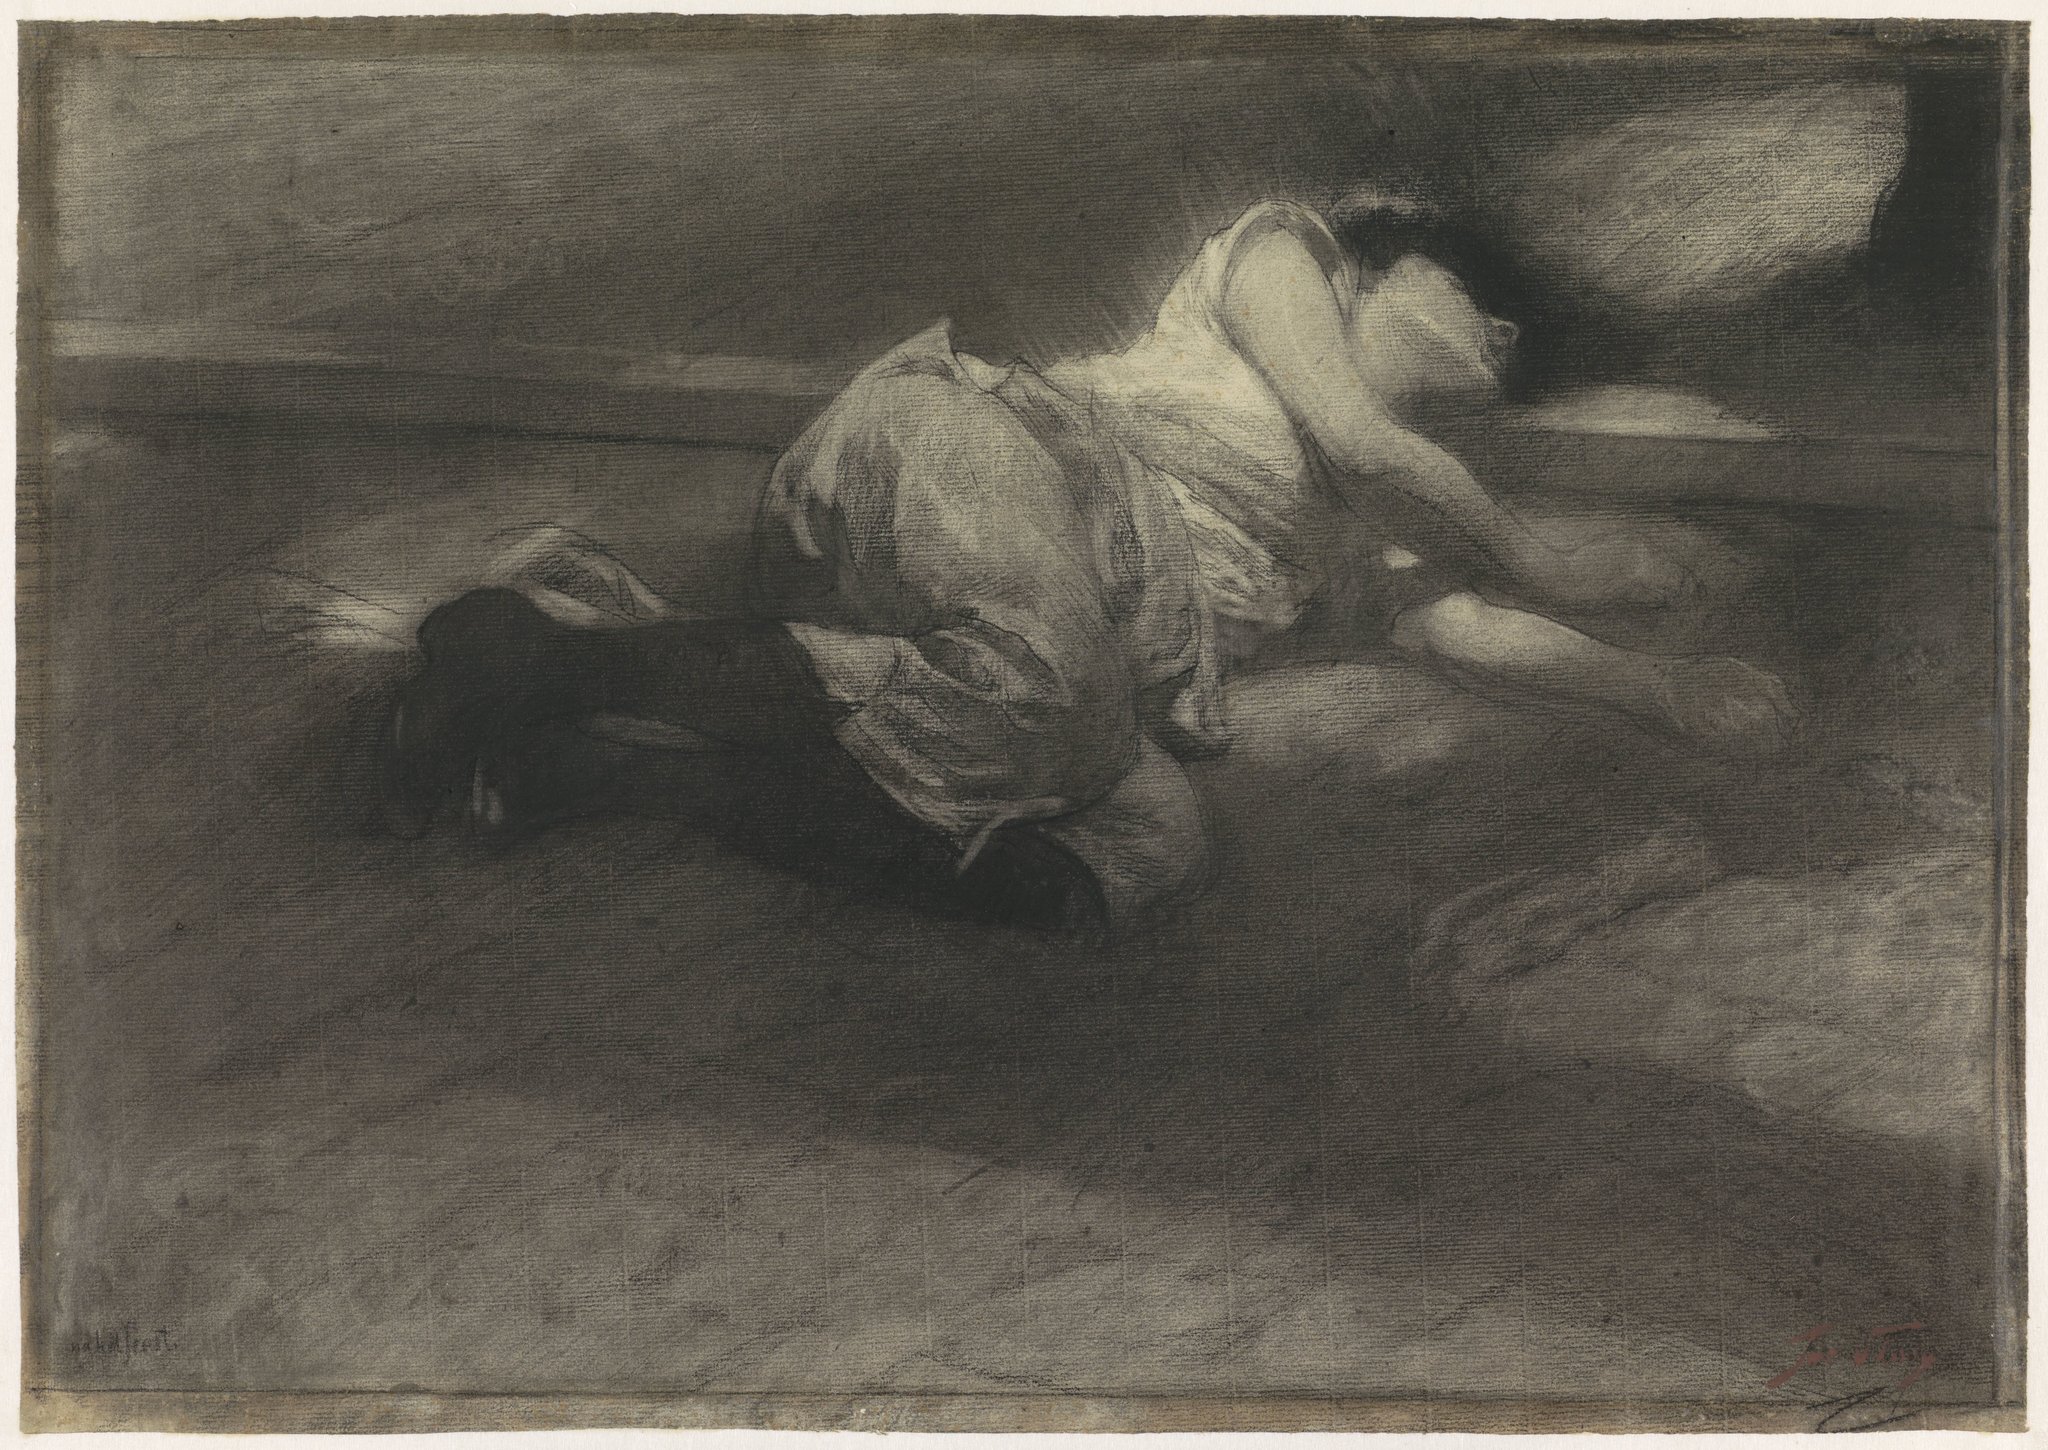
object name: drawing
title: After the Party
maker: jac van looij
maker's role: draughtsman, painter, print maker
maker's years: 1855-1930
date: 1890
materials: chalk, paper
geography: amsterdam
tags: drunkenness, lying figure - aa - female human figure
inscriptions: annotation: ‘na het feest’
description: Fortunately Van Looij wrote the title ‘After the party’ on the drawing. A drunken woman in the gutter, her undergarments visible, was a risqué subject in his time. As an artist and writer, Van Looij was fascinated by street parties: his descriptions elucidate how he felt both an ‘aristocratic’ attraction and condemnation. In the excesses of the pleasures of life, the differences between rich and poor vanish and everyone is equal.